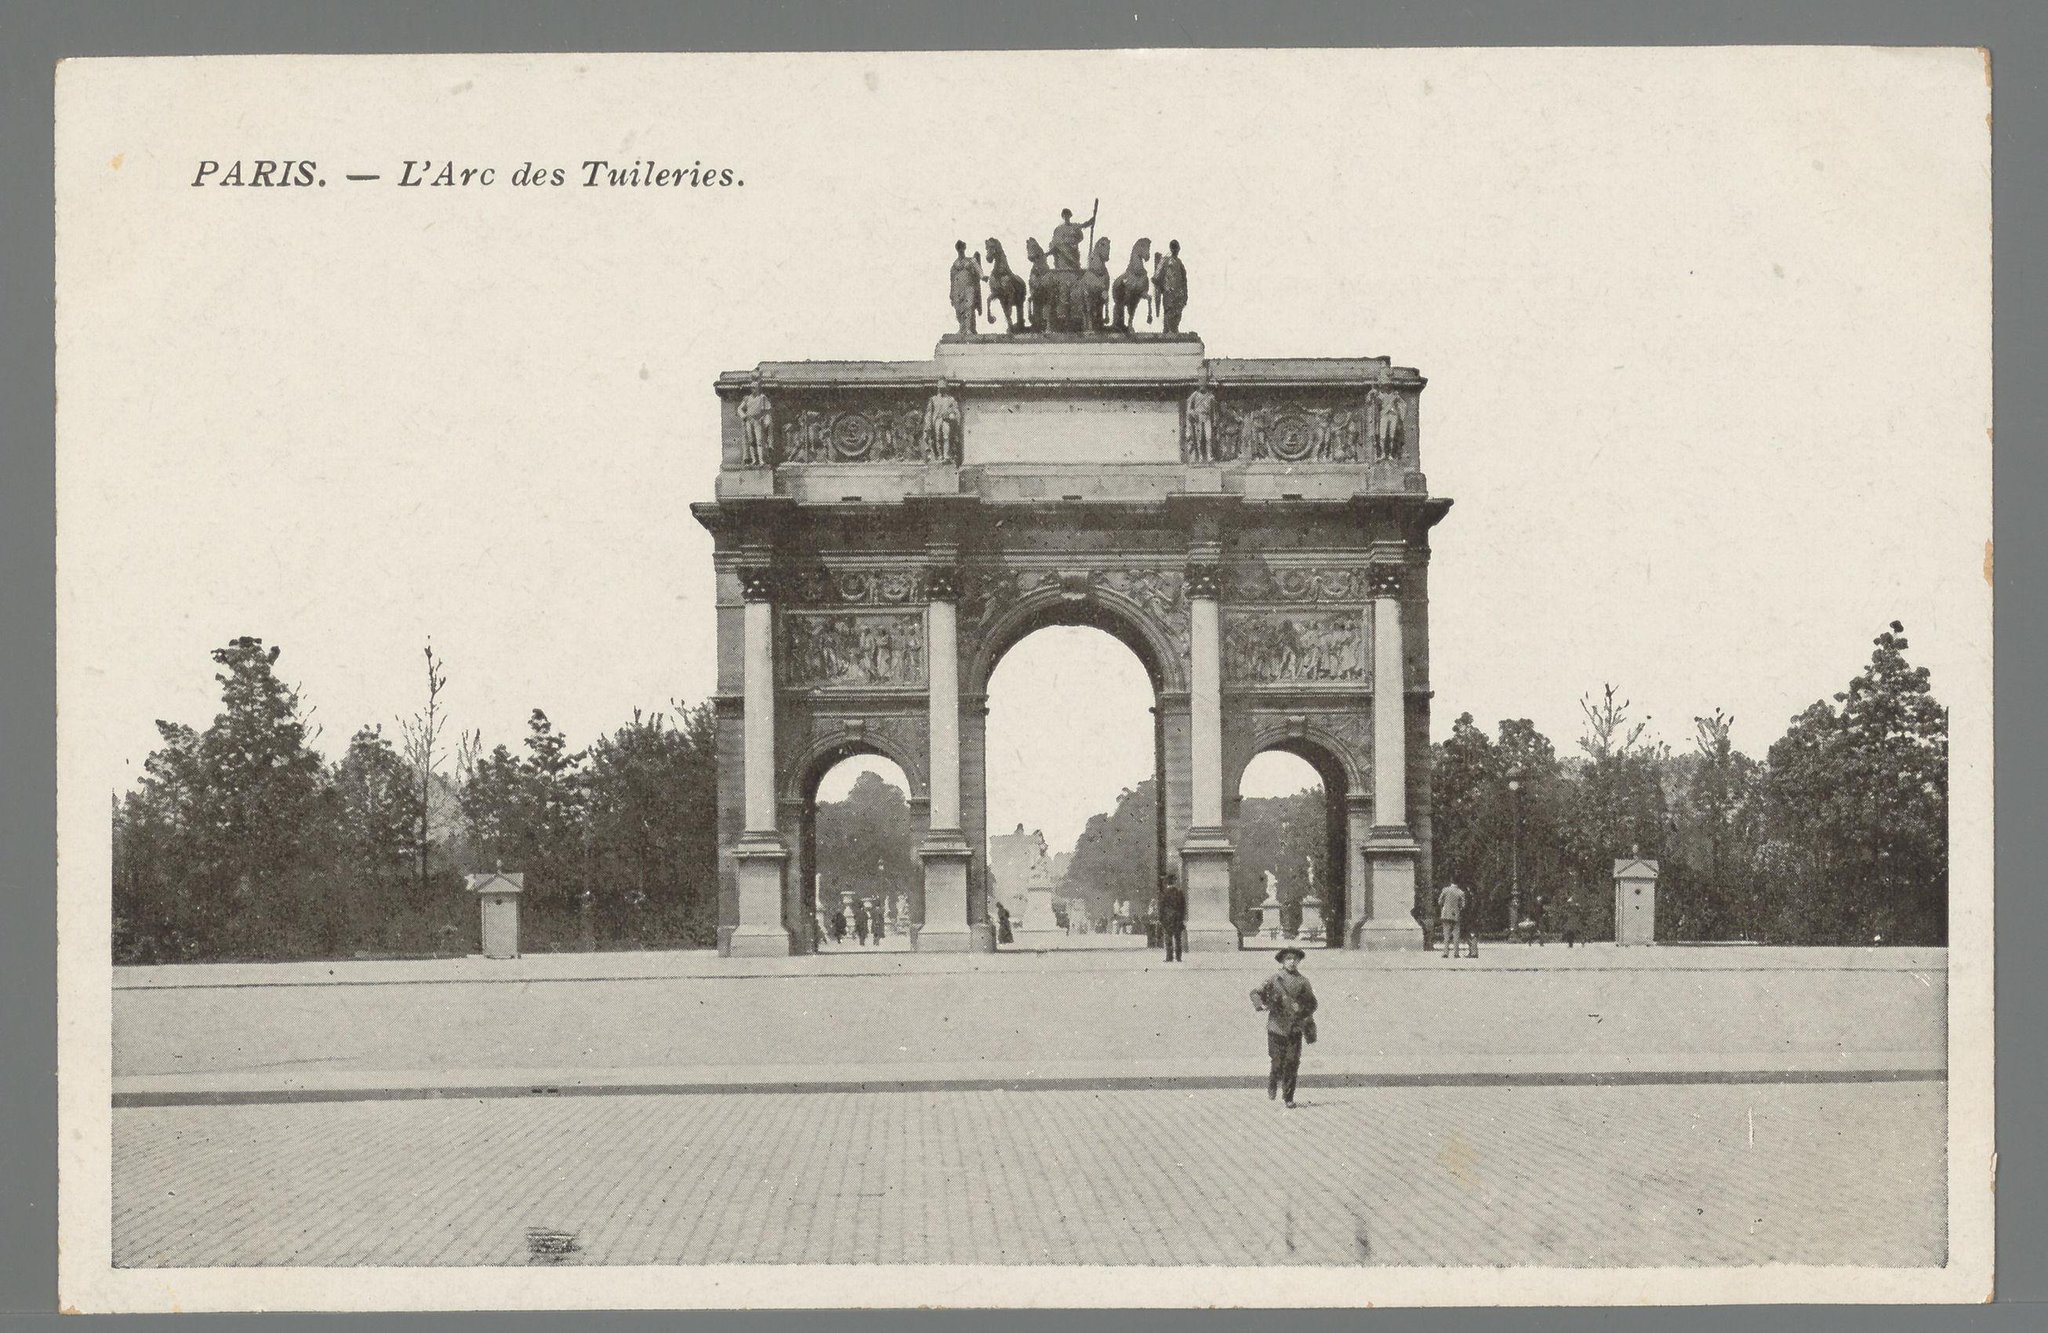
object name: ansichtkaart, prentbriefkaart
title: Paris. L'Arc des Tuileries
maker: Anonymous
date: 1904-1906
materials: cardboard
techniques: autotype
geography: paris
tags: monument, statue, square, place, circus, etc. (+ city(-scape) with figures, staffage), paris